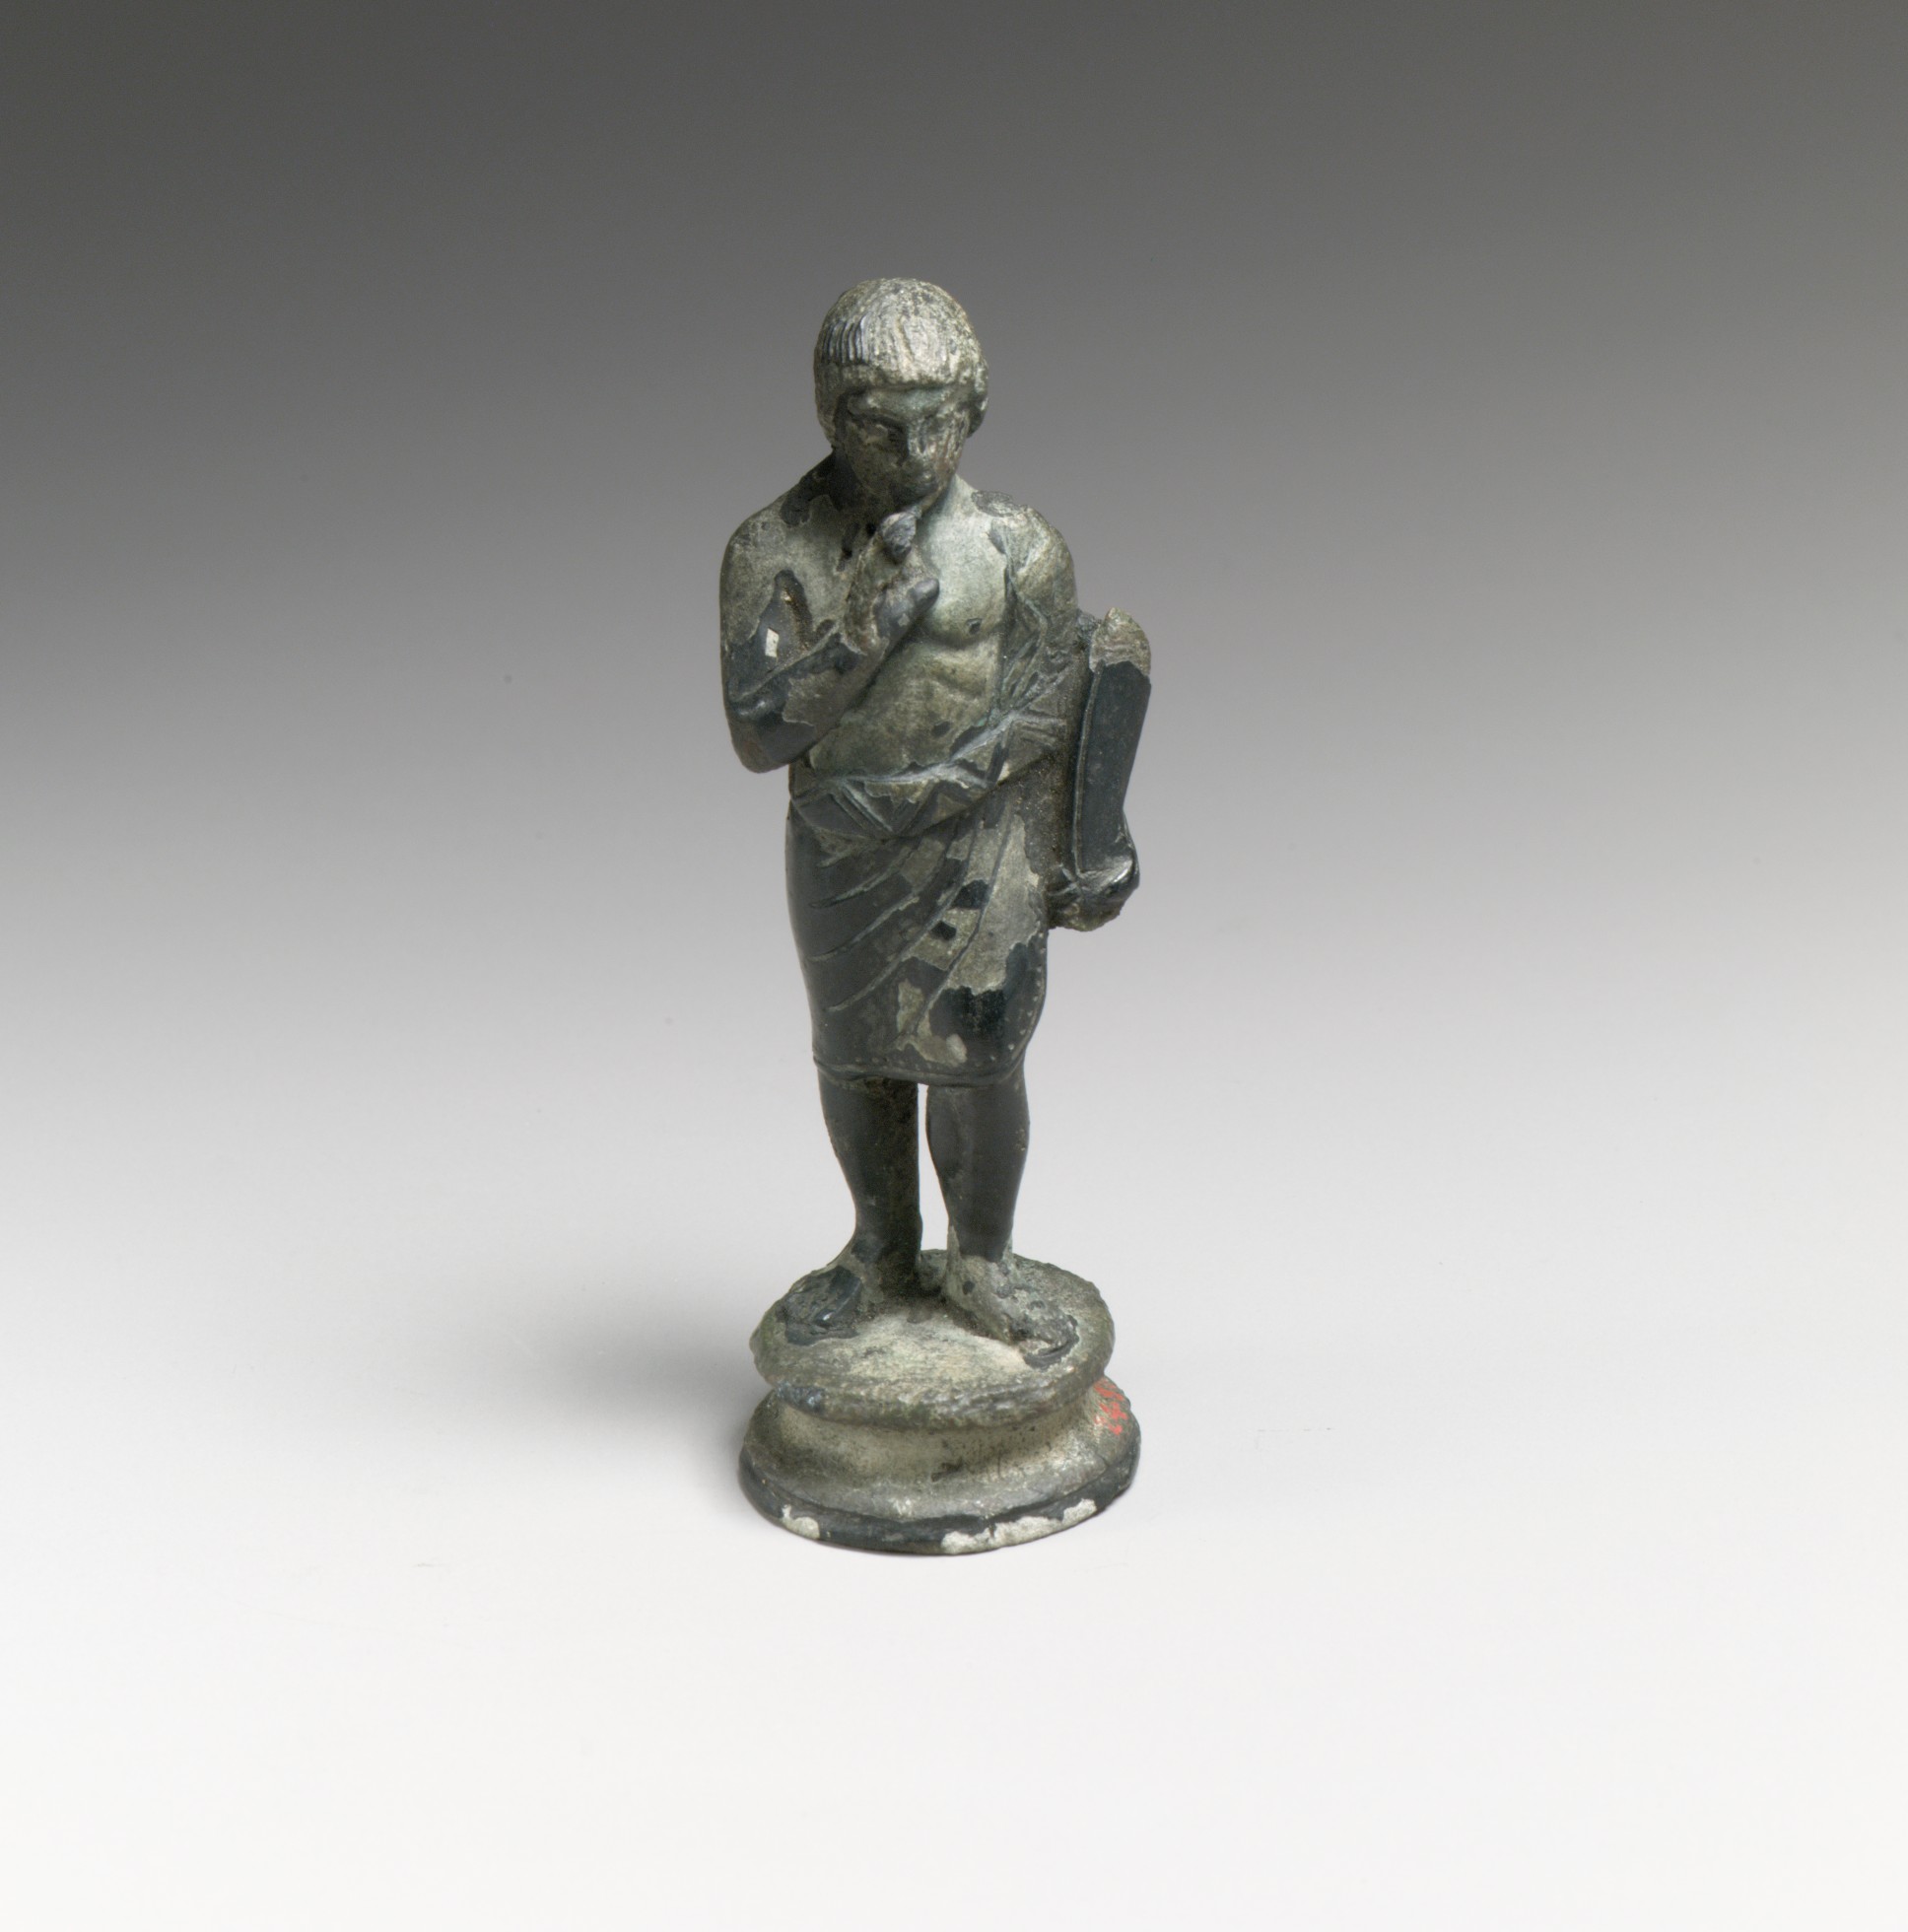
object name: statuette of a youth harpokrates with knife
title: Bronze statuette of a youth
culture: etruscan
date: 500-401 BCE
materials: bronze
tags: men